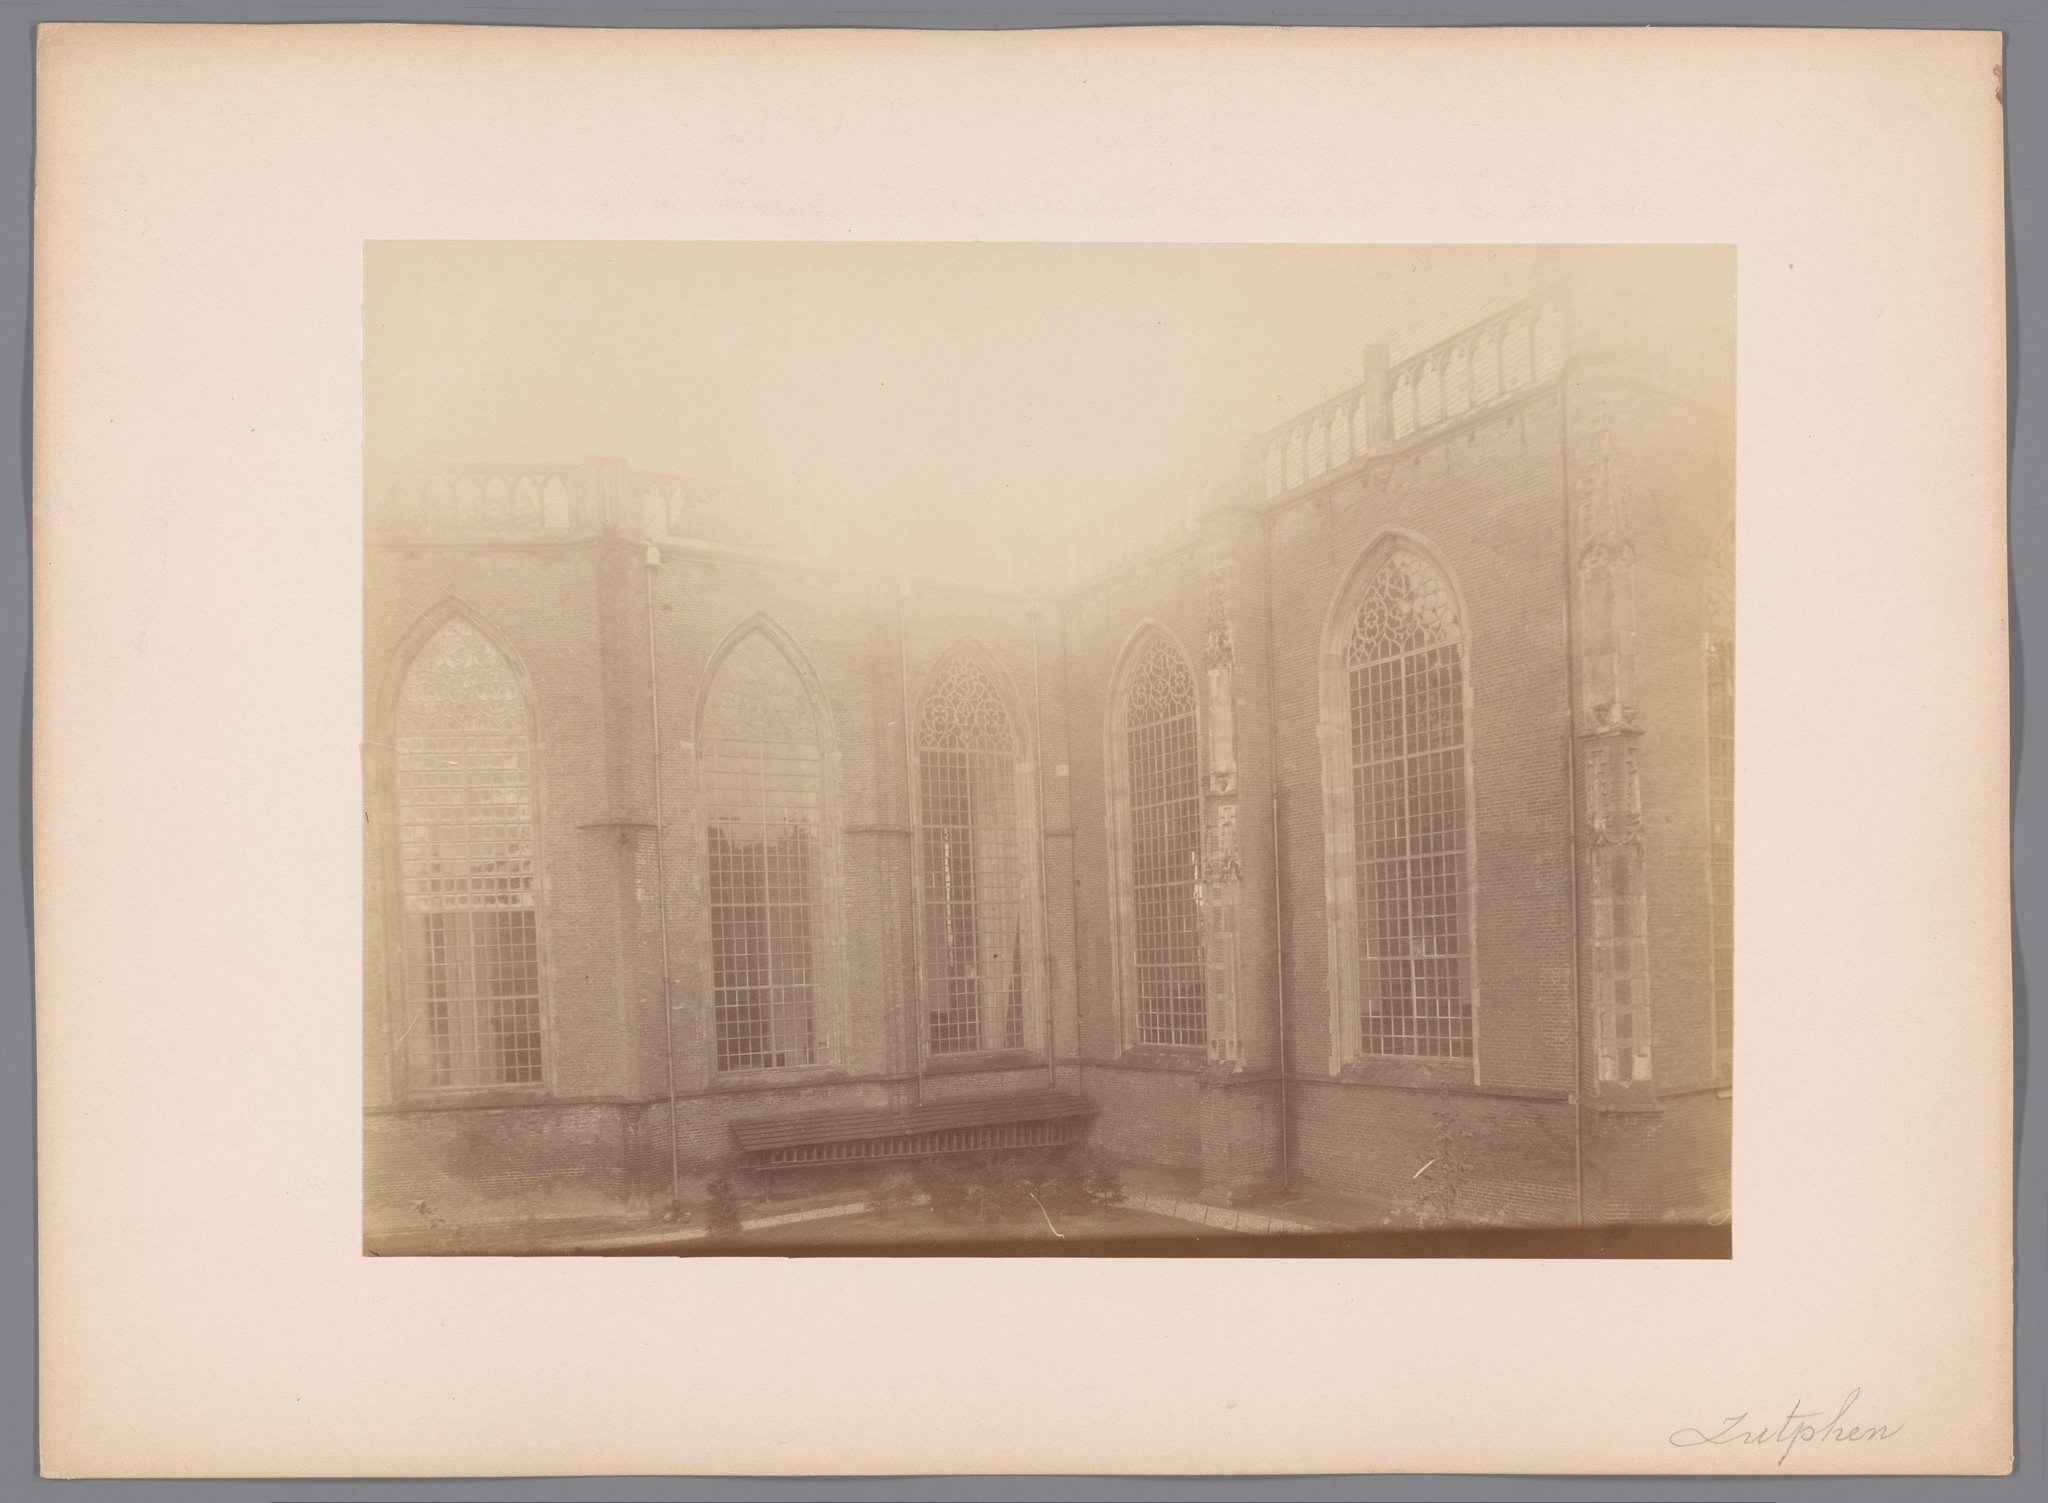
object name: photograph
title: Gedeelte van de Sint Walburgiskerk te Zutphen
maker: anoniem (monumentenzorg)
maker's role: fotograaf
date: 1890-1910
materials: cardboard, photographic support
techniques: albumen print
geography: zutphen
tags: church (exterior)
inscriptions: annotation: ‘Zutphen’, annotation: ‘Zutphen/ Aanzicht [...] koor en Noor transept van de Ned. Herv. Kerk’